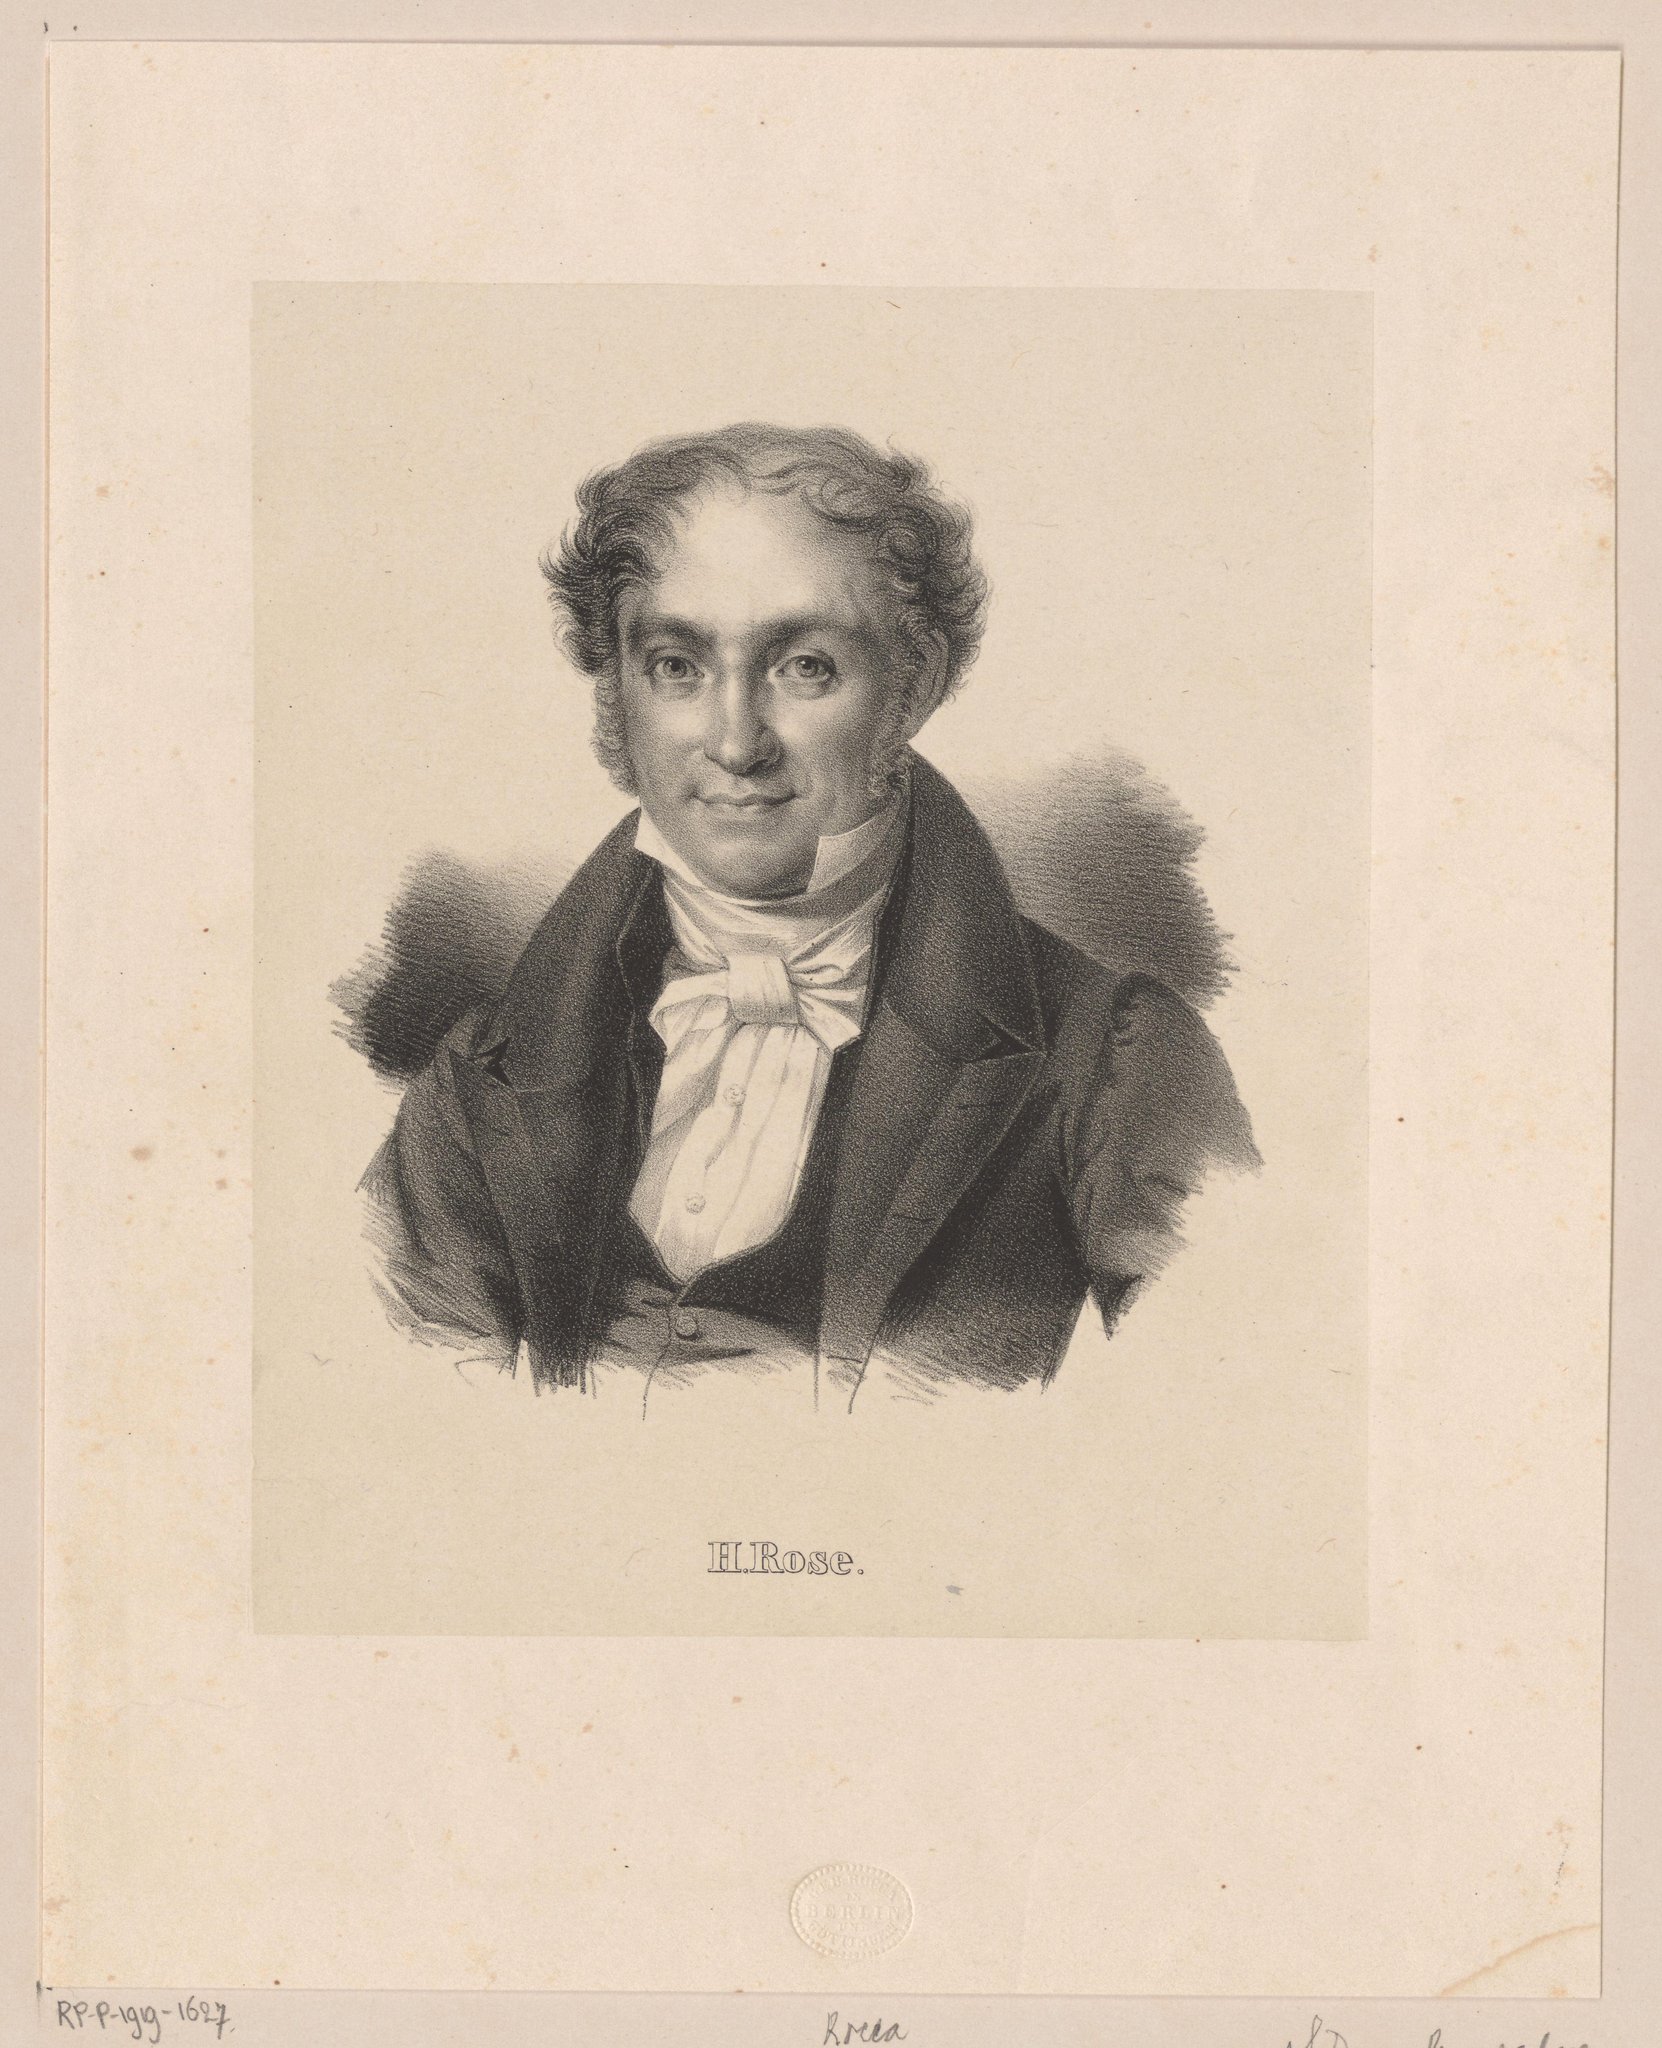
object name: print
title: Portret van Heinrich Rose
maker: Anonymous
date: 1830-1863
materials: paper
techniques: lithograph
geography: gottingen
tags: historical persons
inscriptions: check stamp: Lugt 5514, collector's mark: Lugt 2228